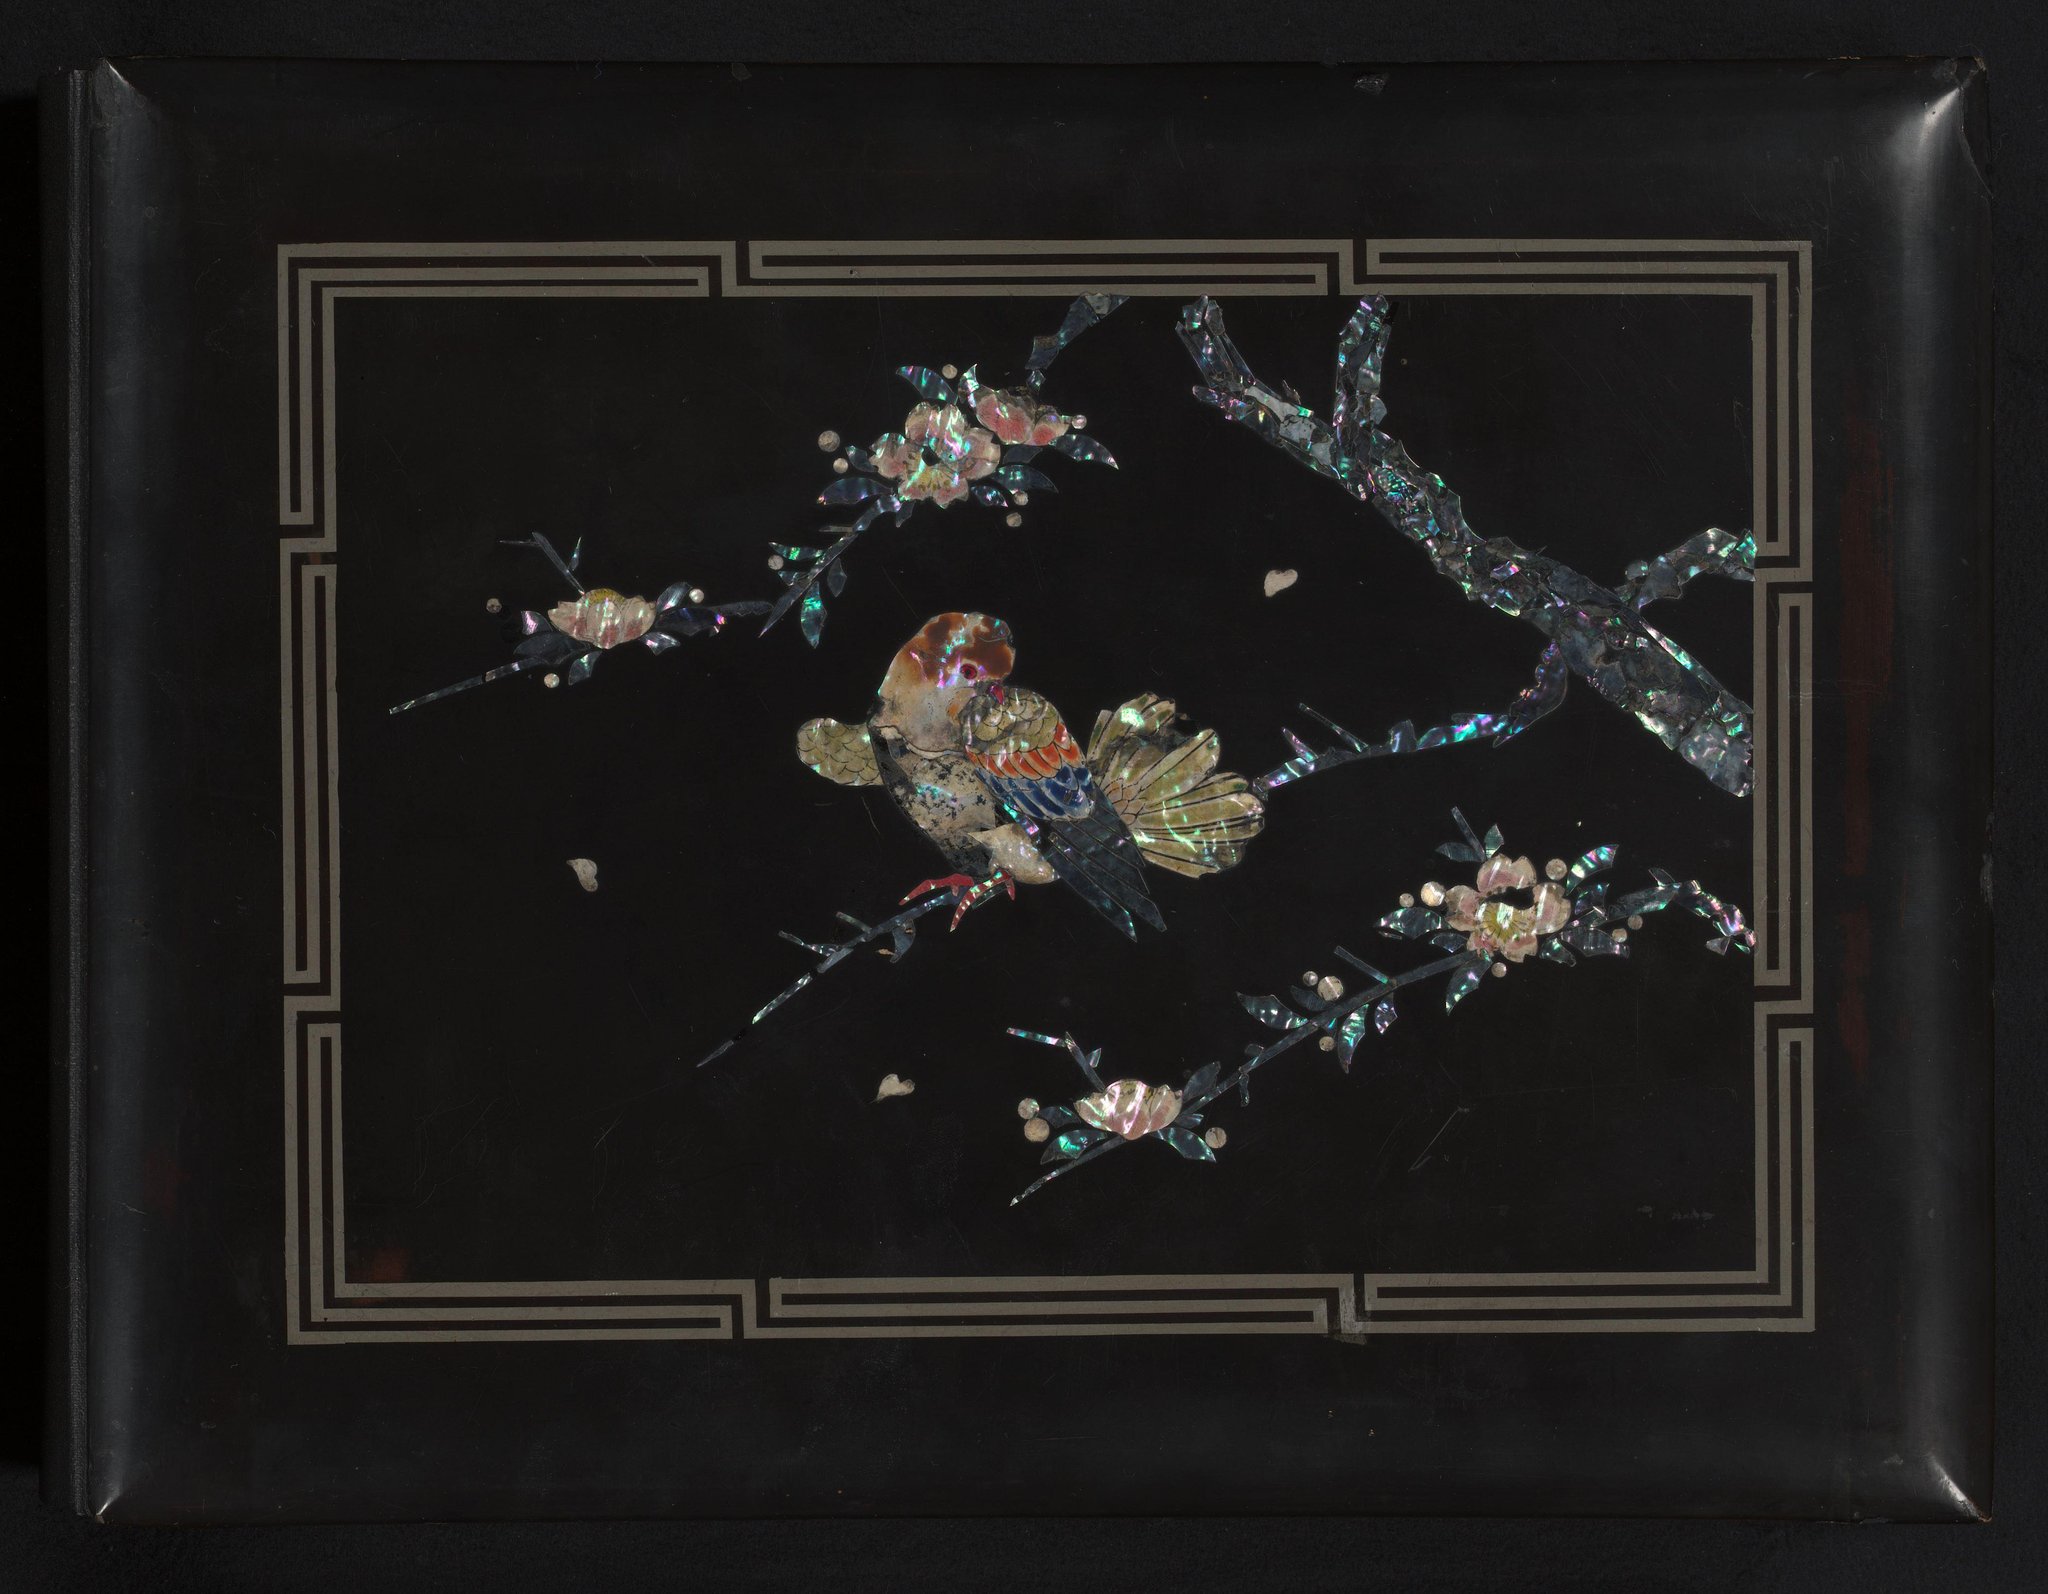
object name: photograph album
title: Fotoalbum met 58 prentbriefkaarten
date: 1860-1920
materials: cardboard, paint, leather, lacquer, mother of pearl, paper, photographic support, silk, textile, watercolor, wood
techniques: blind stamped, brush, photograph, gelatin silver print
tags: flowers, adult woman, city-view in general; 'veduta', historical persons, queen, king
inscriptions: inscription: ‘Dienst/ Verspreide/ Rijkskollekties (...)’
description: Fotoalbum met 18 pagina's met in totaal 58 prentbriefkaarten. Het album bevat meerdere prentbriefkaarten met portretten van koningin Wilhelmina en Hendrik maar ook met landschappen en verjaardagskaarten met portretten van een vrouw.